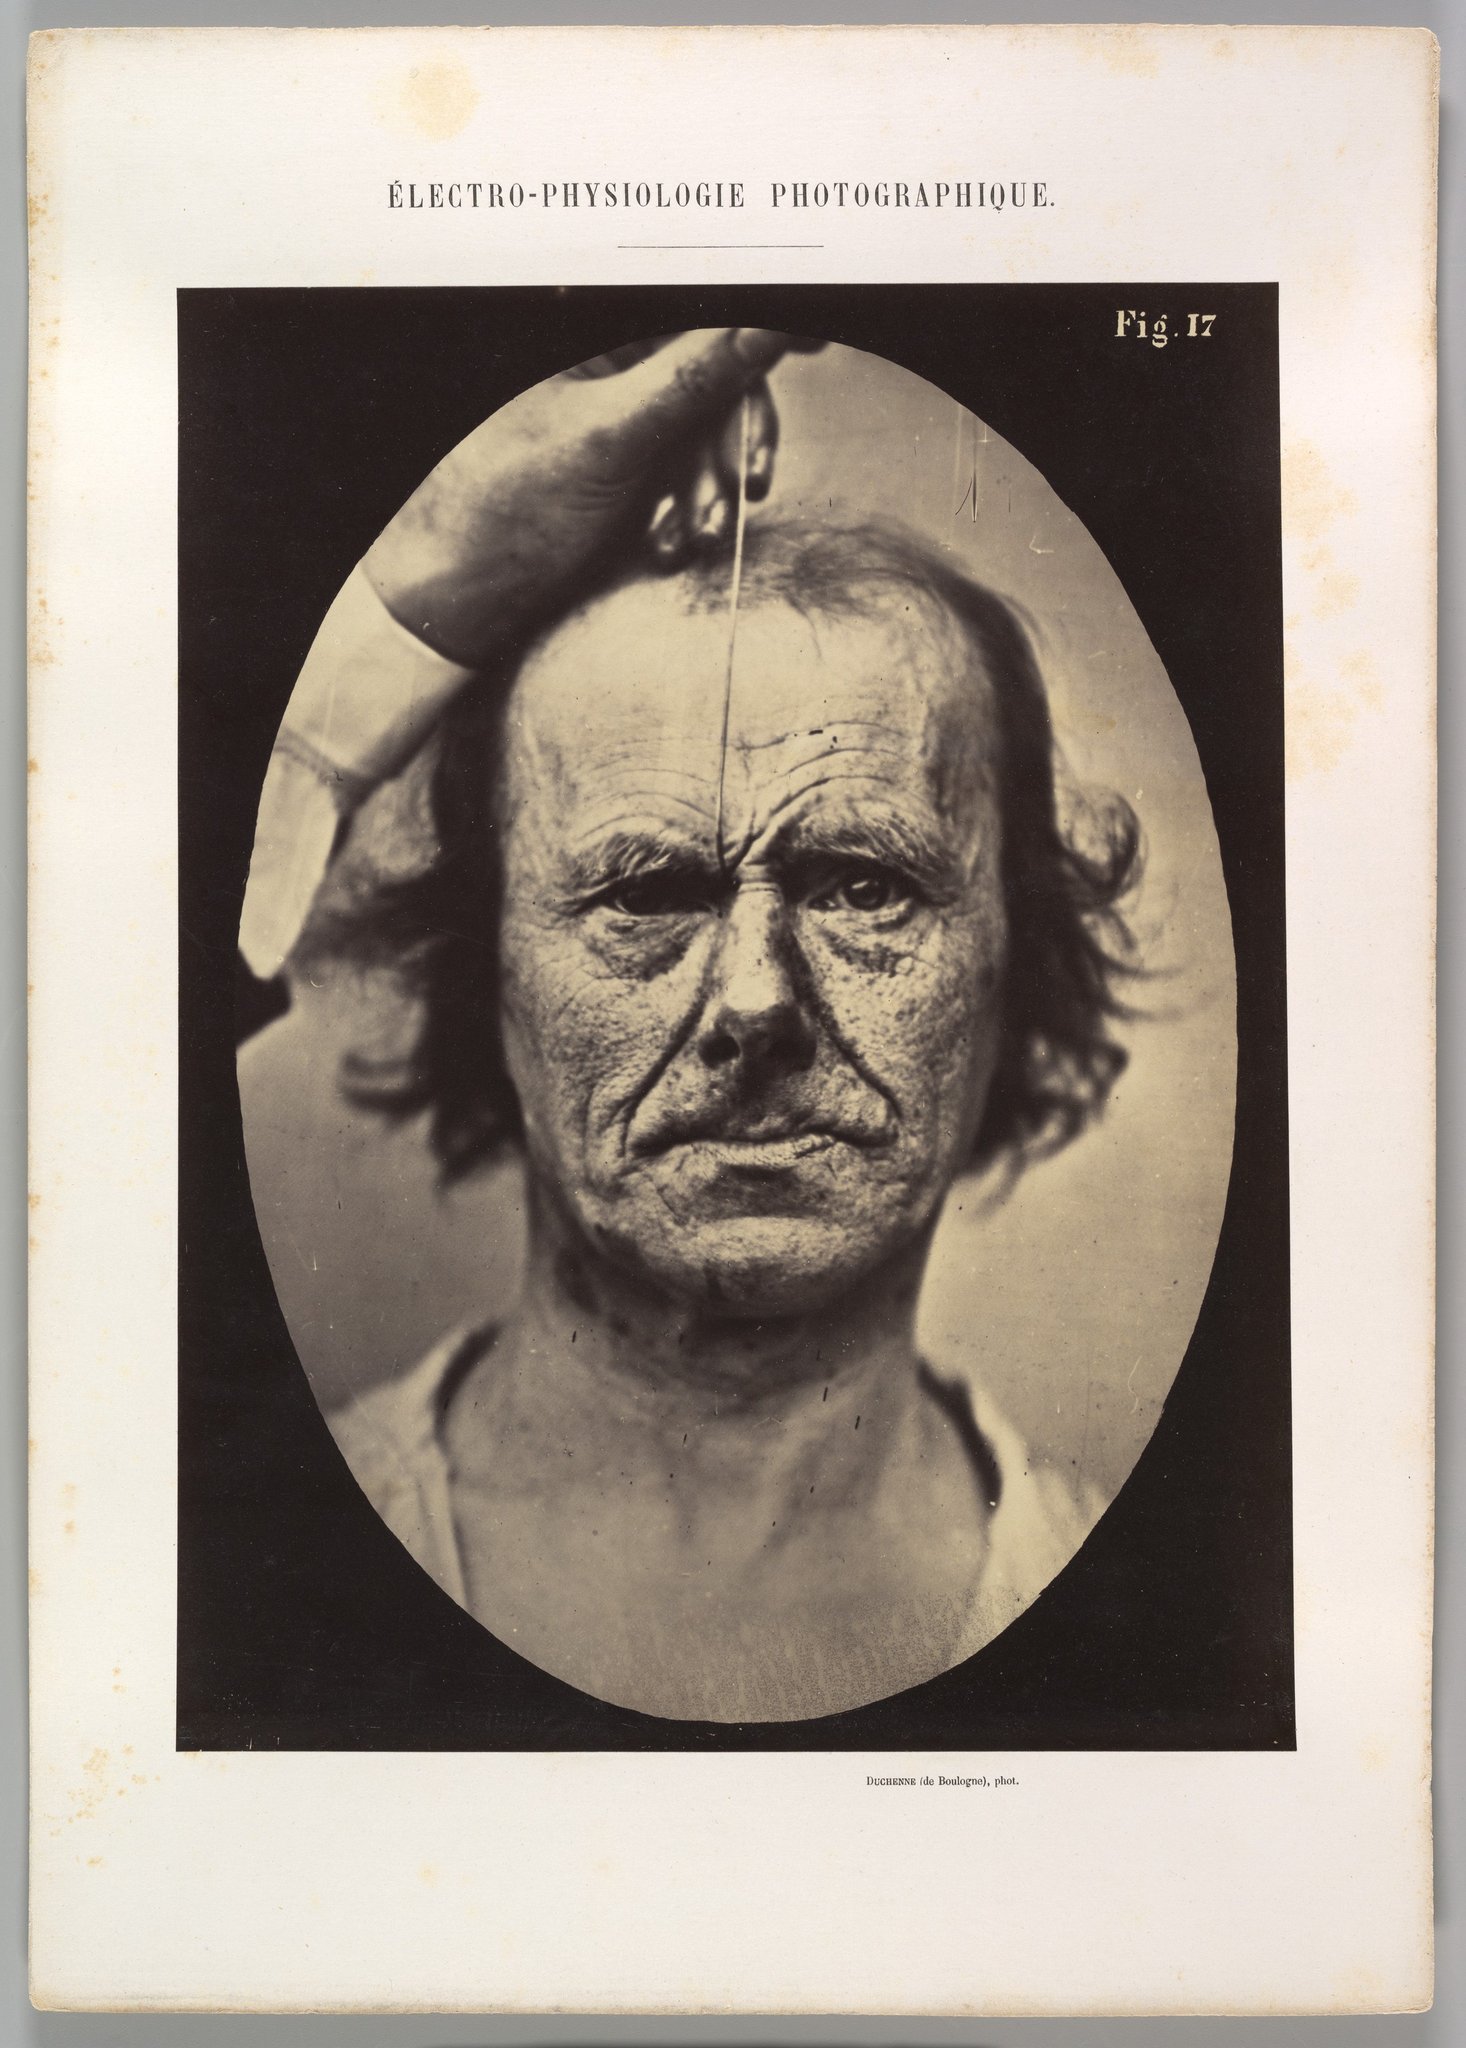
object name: photograph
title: Figure 17: On the right, electrization of m. procerus: severity, aggression. On the left: attention.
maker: guillaume-benjamin-amand duchenne de boulogne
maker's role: artist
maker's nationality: french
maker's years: 1806-1875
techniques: albumen silver print, glass negative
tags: science,men,portraits